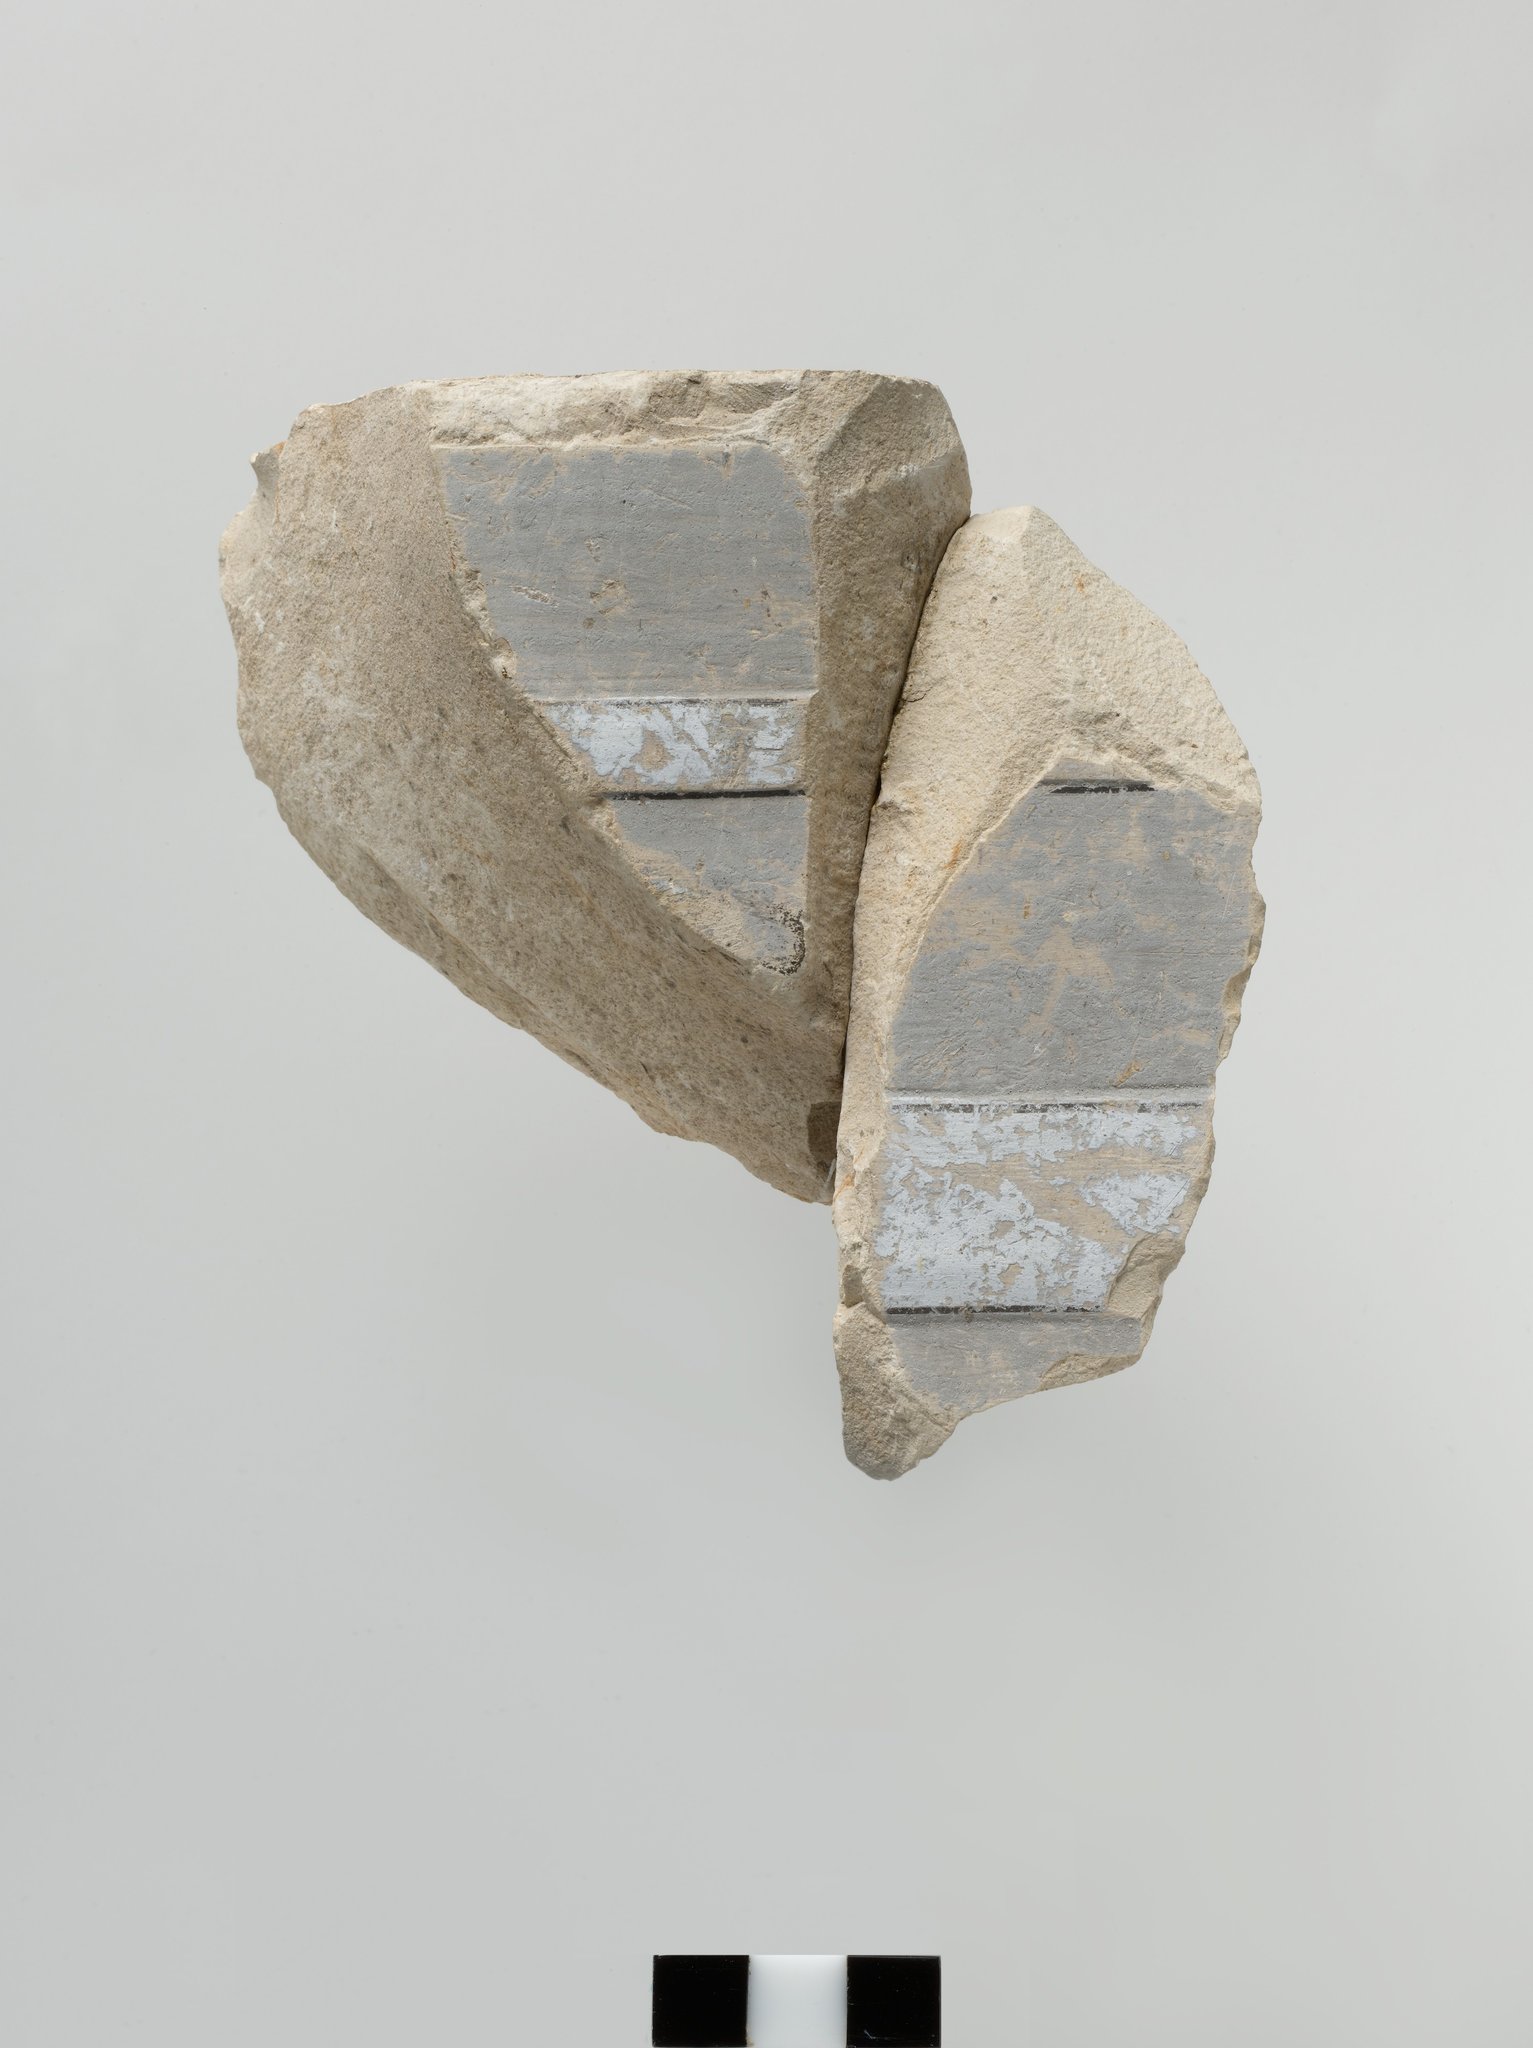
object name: relief fragment, tomb of meketre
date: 1981-1975 BCE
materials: limestone, paint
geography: egypt